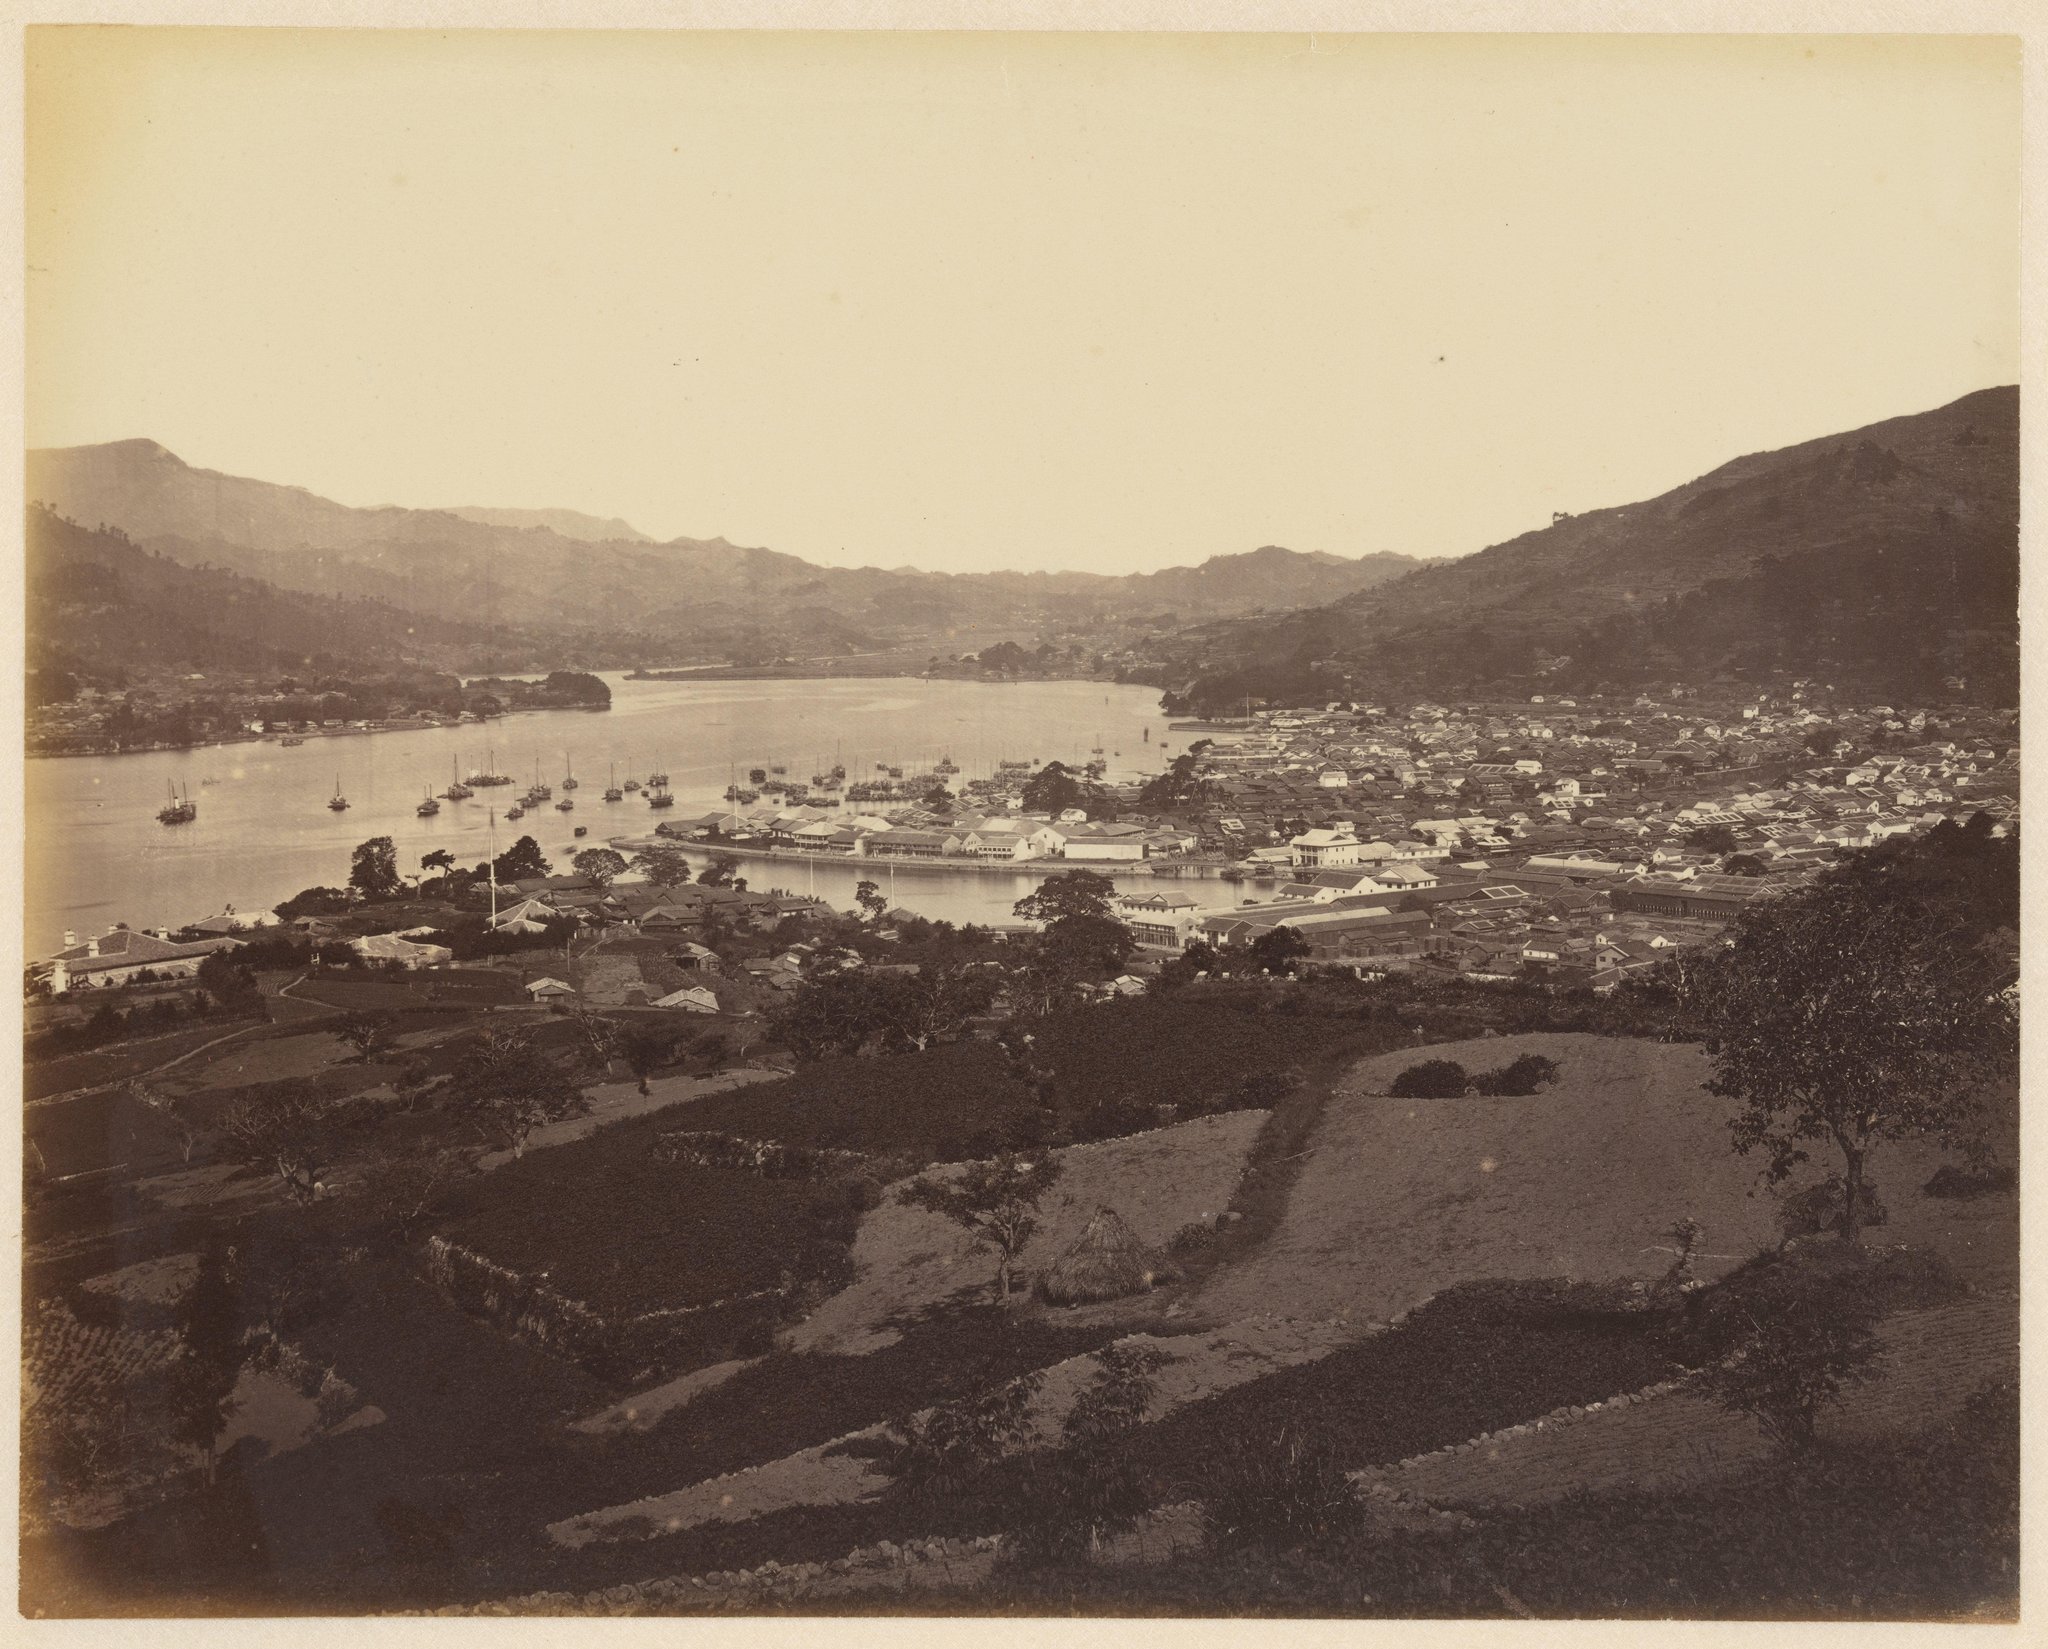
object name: photograph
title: View of Dejima (centre) and Nagasaki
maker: Anonymous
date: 1865-1870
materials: paper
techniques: albumen print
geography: japan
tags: deshima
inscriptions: number: ‘BL3’, number: ‘K5’, number: ‘BD199’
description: What better souvenir of Japan than a series of photographs? Professional photographers catered to those who did not take pictures themselves. Gradually, Japan developed a market for photos of cities, temples and similar attractions. Bird’s-eye views like this one of Nagasaki were popular, presenting a compact overview of a place wholly unfamiliar to most people back home.